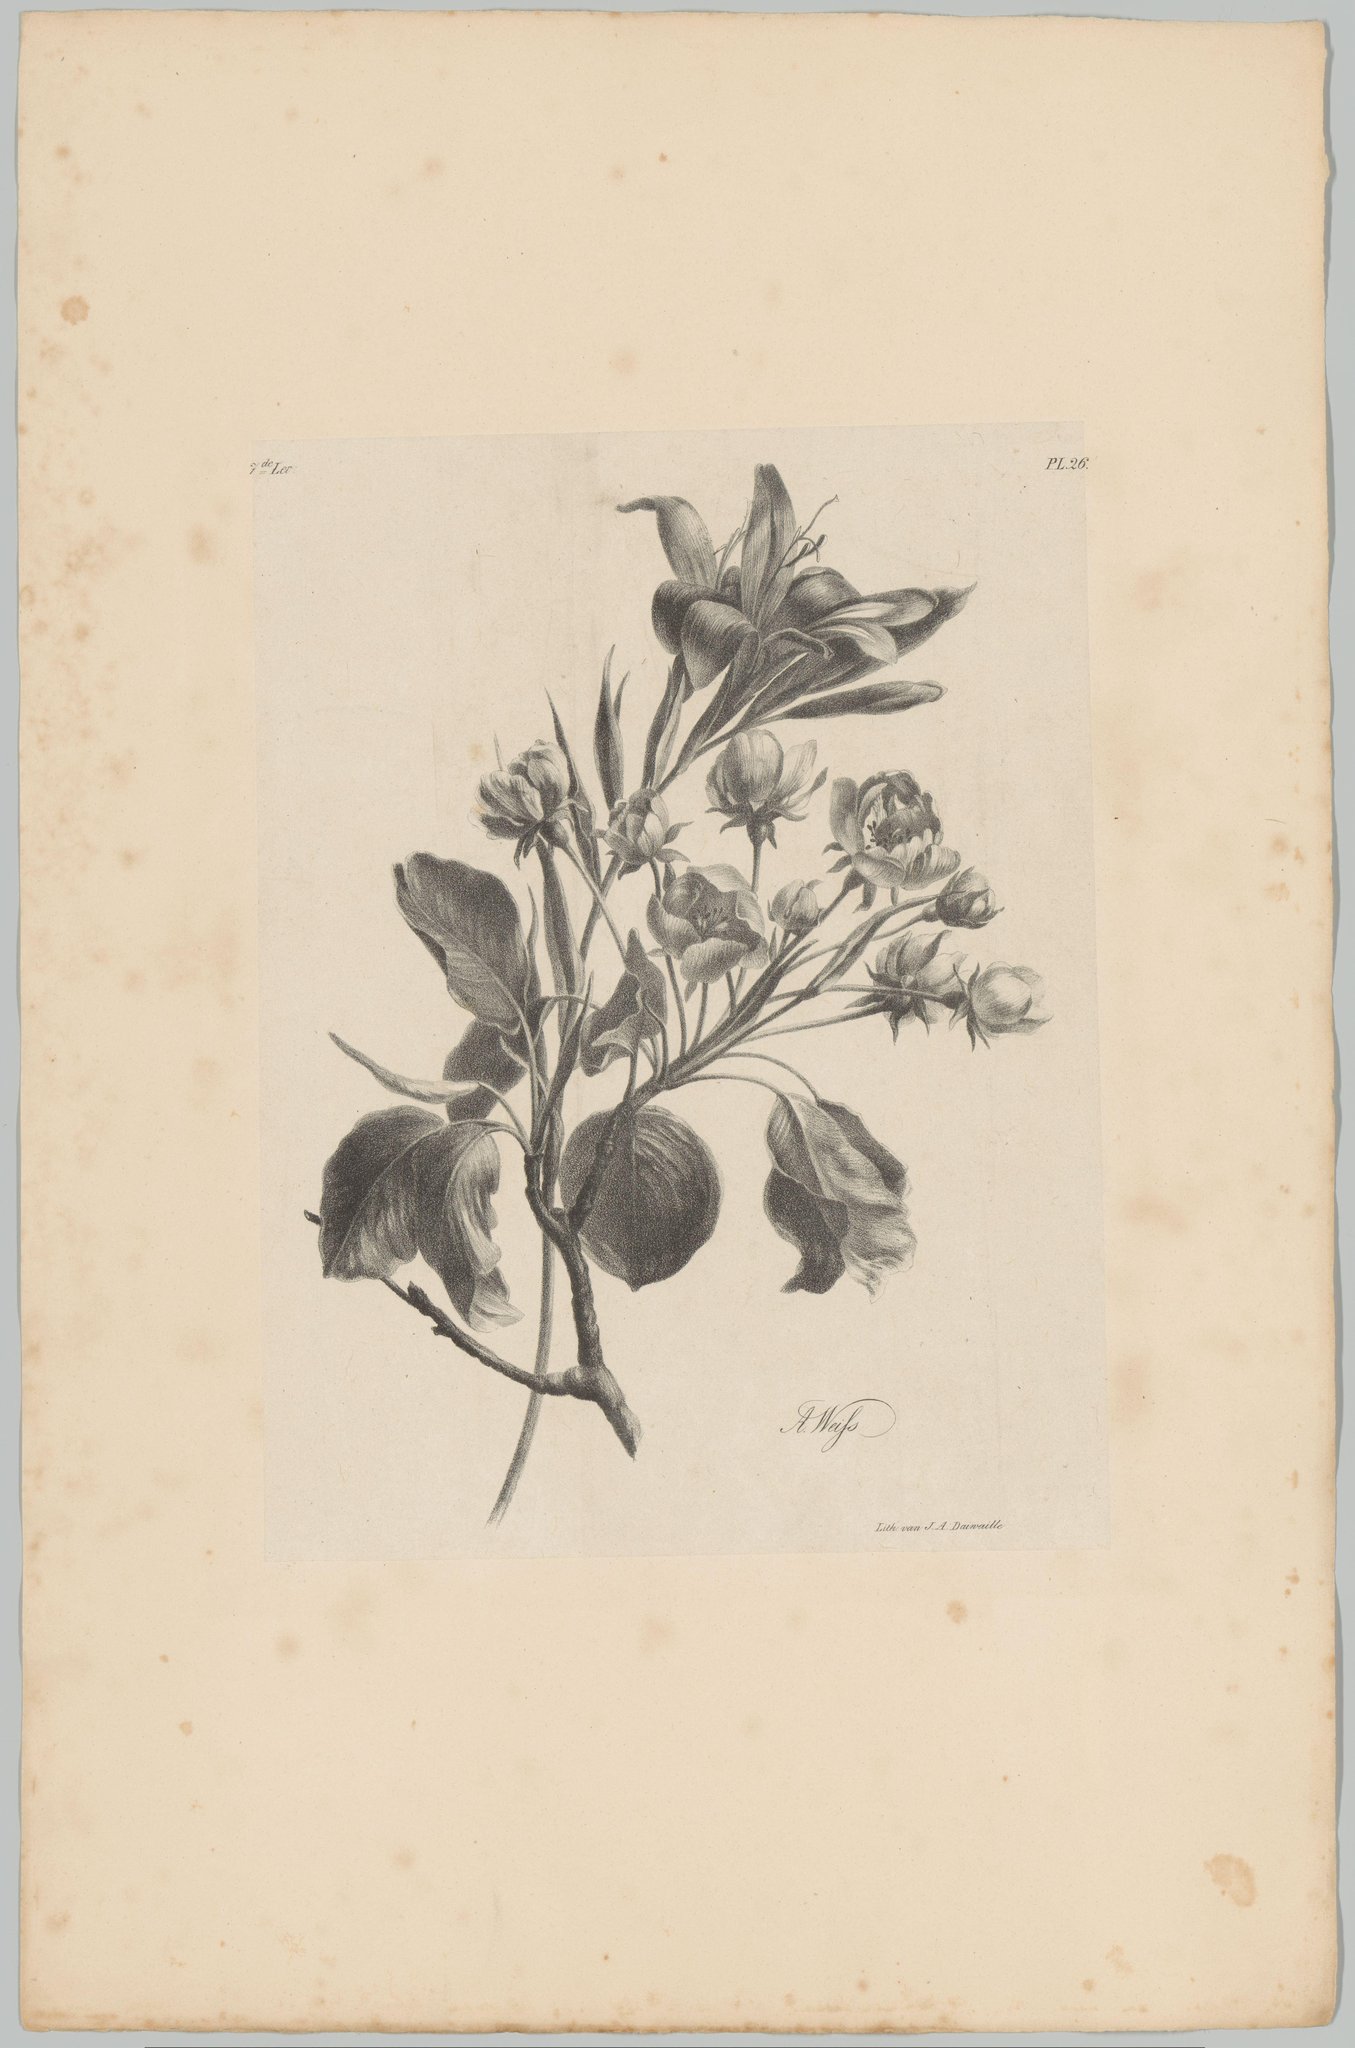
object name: print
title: Lelie en andere bloemen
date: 1820-1833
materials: paper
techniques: lithograph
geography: amsterdam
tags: flowers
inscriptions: collector's mark: Lugt 2228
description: Links boven genummerd 7de Lev. Onderdeel van een omslag met in totaal zevenenzeventig lithografieën van bloemen en fruit.